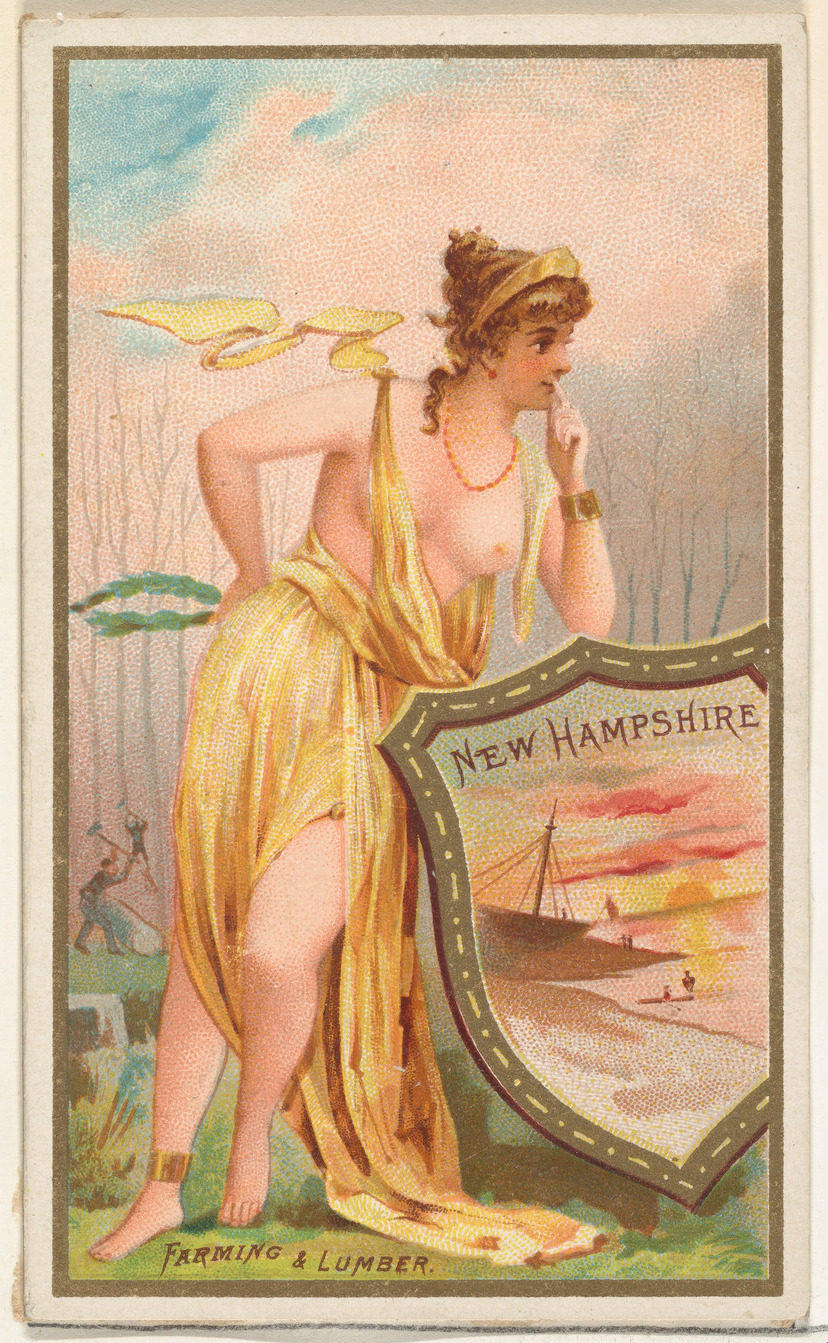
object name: print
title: New Hampshire, from the Industries of States series (N117) issued by Duke Sons & Co. to promote Honest Long Cut Tobacco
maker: w. duke, sons & co.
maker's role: publisher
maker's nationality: american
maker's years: 1870-1920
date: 1889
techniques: color lithograph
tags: shields,female nudes